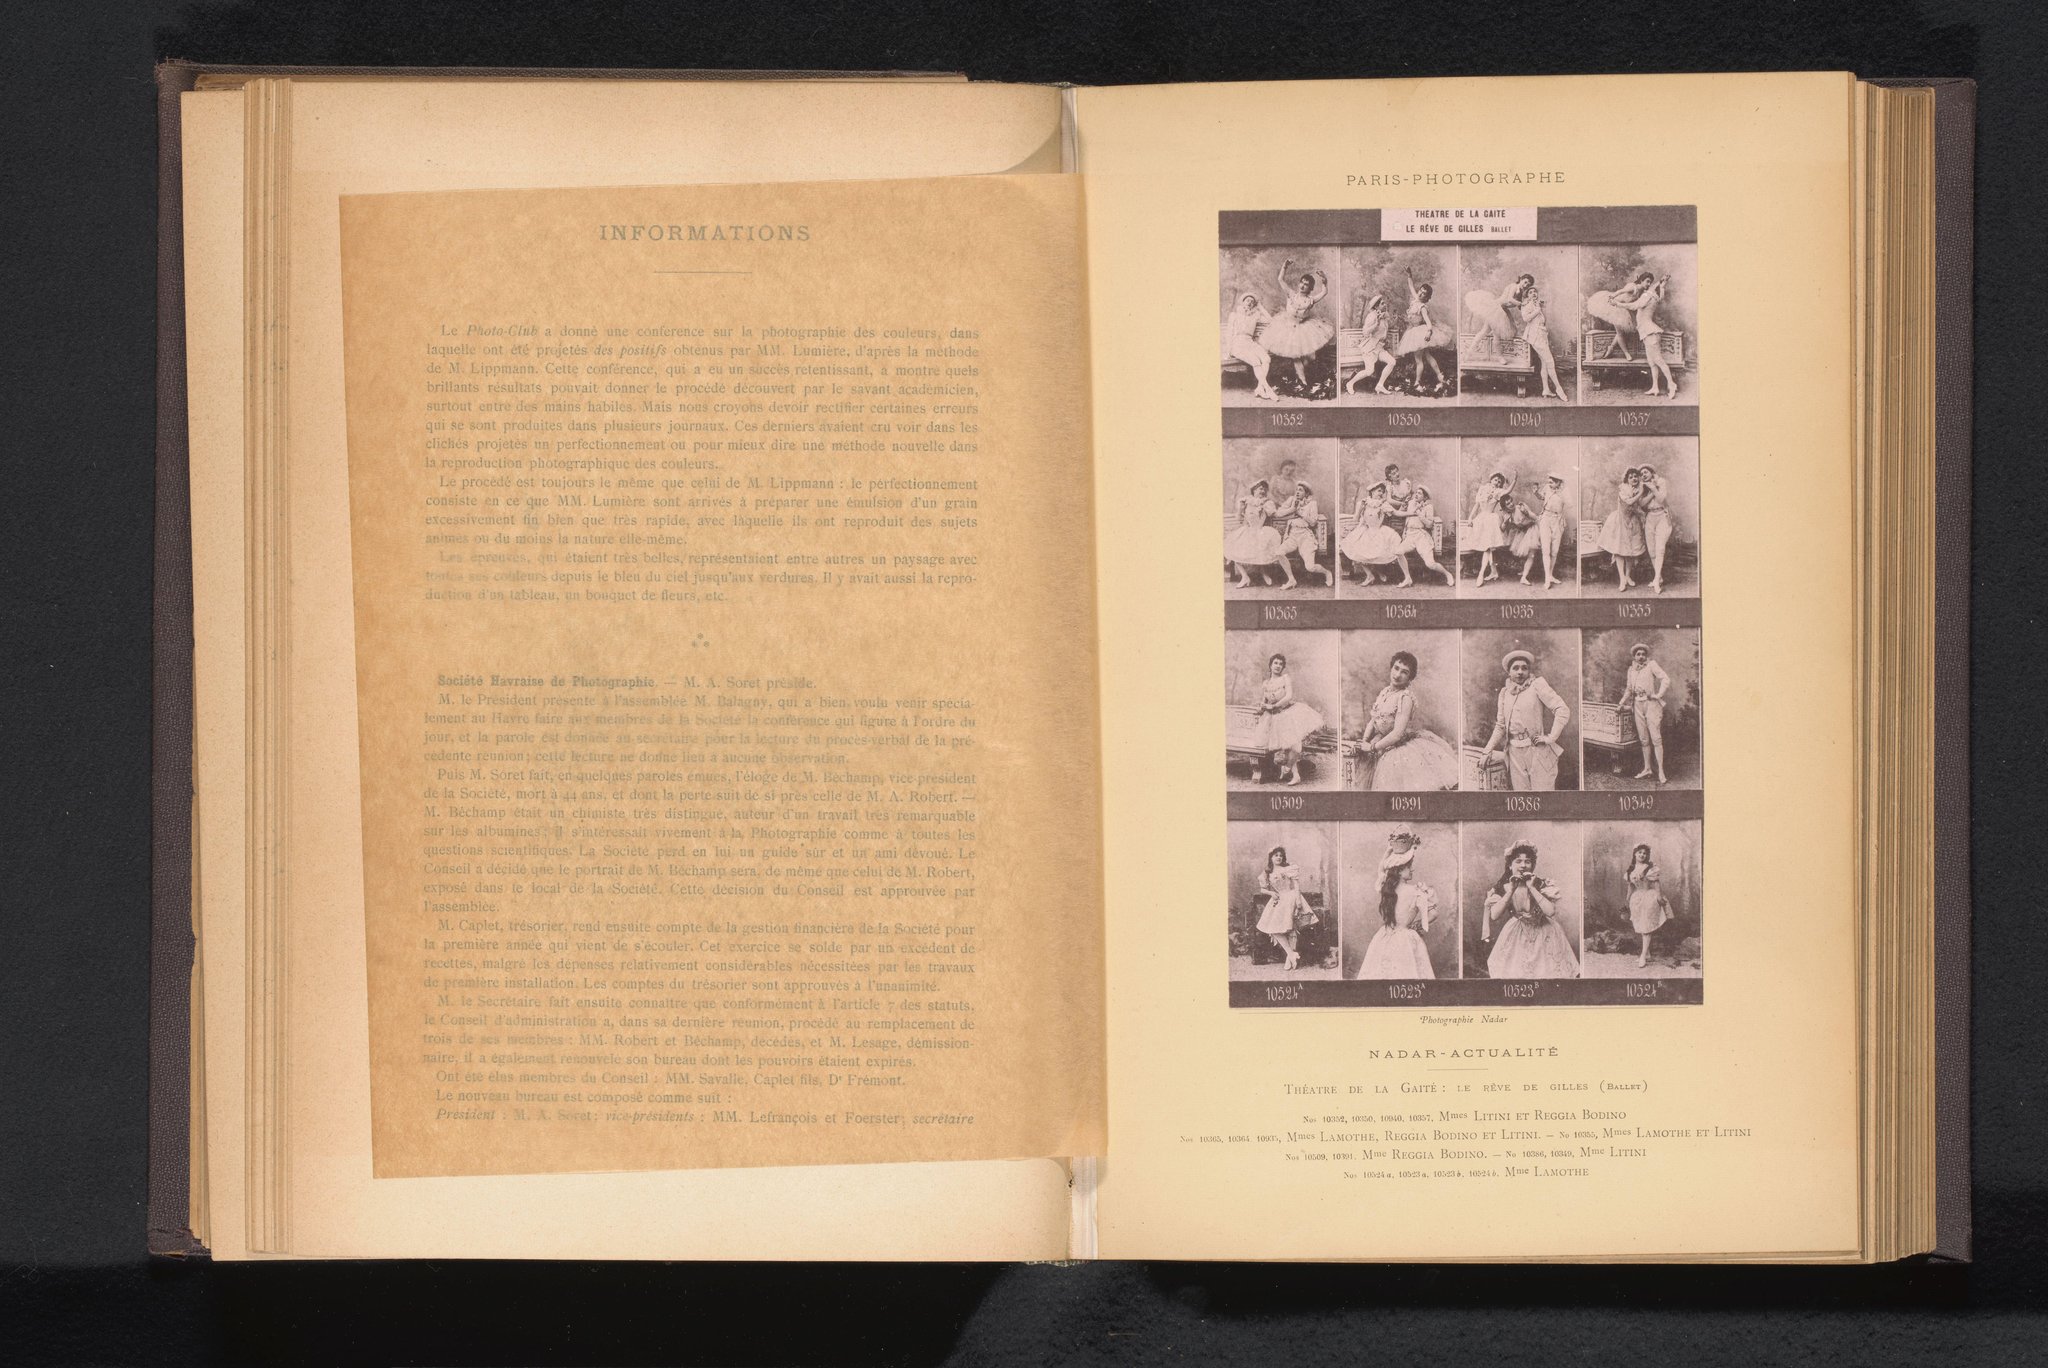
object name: photomechanical print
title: Zestien portretten van balletdansers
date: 1883-1893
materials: paper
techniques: photograph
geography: paris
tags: the ballet, ballet performance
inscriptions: inscription: ‘Theatre de la Gaite - Le rève de Gilles (Ballet) (...)’, number: ‘10352 (...) 10524B’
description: Van links naar rechts en van boven naar beneden: Mmes Litini, Reggia Bodino en Mmes Lamothe.